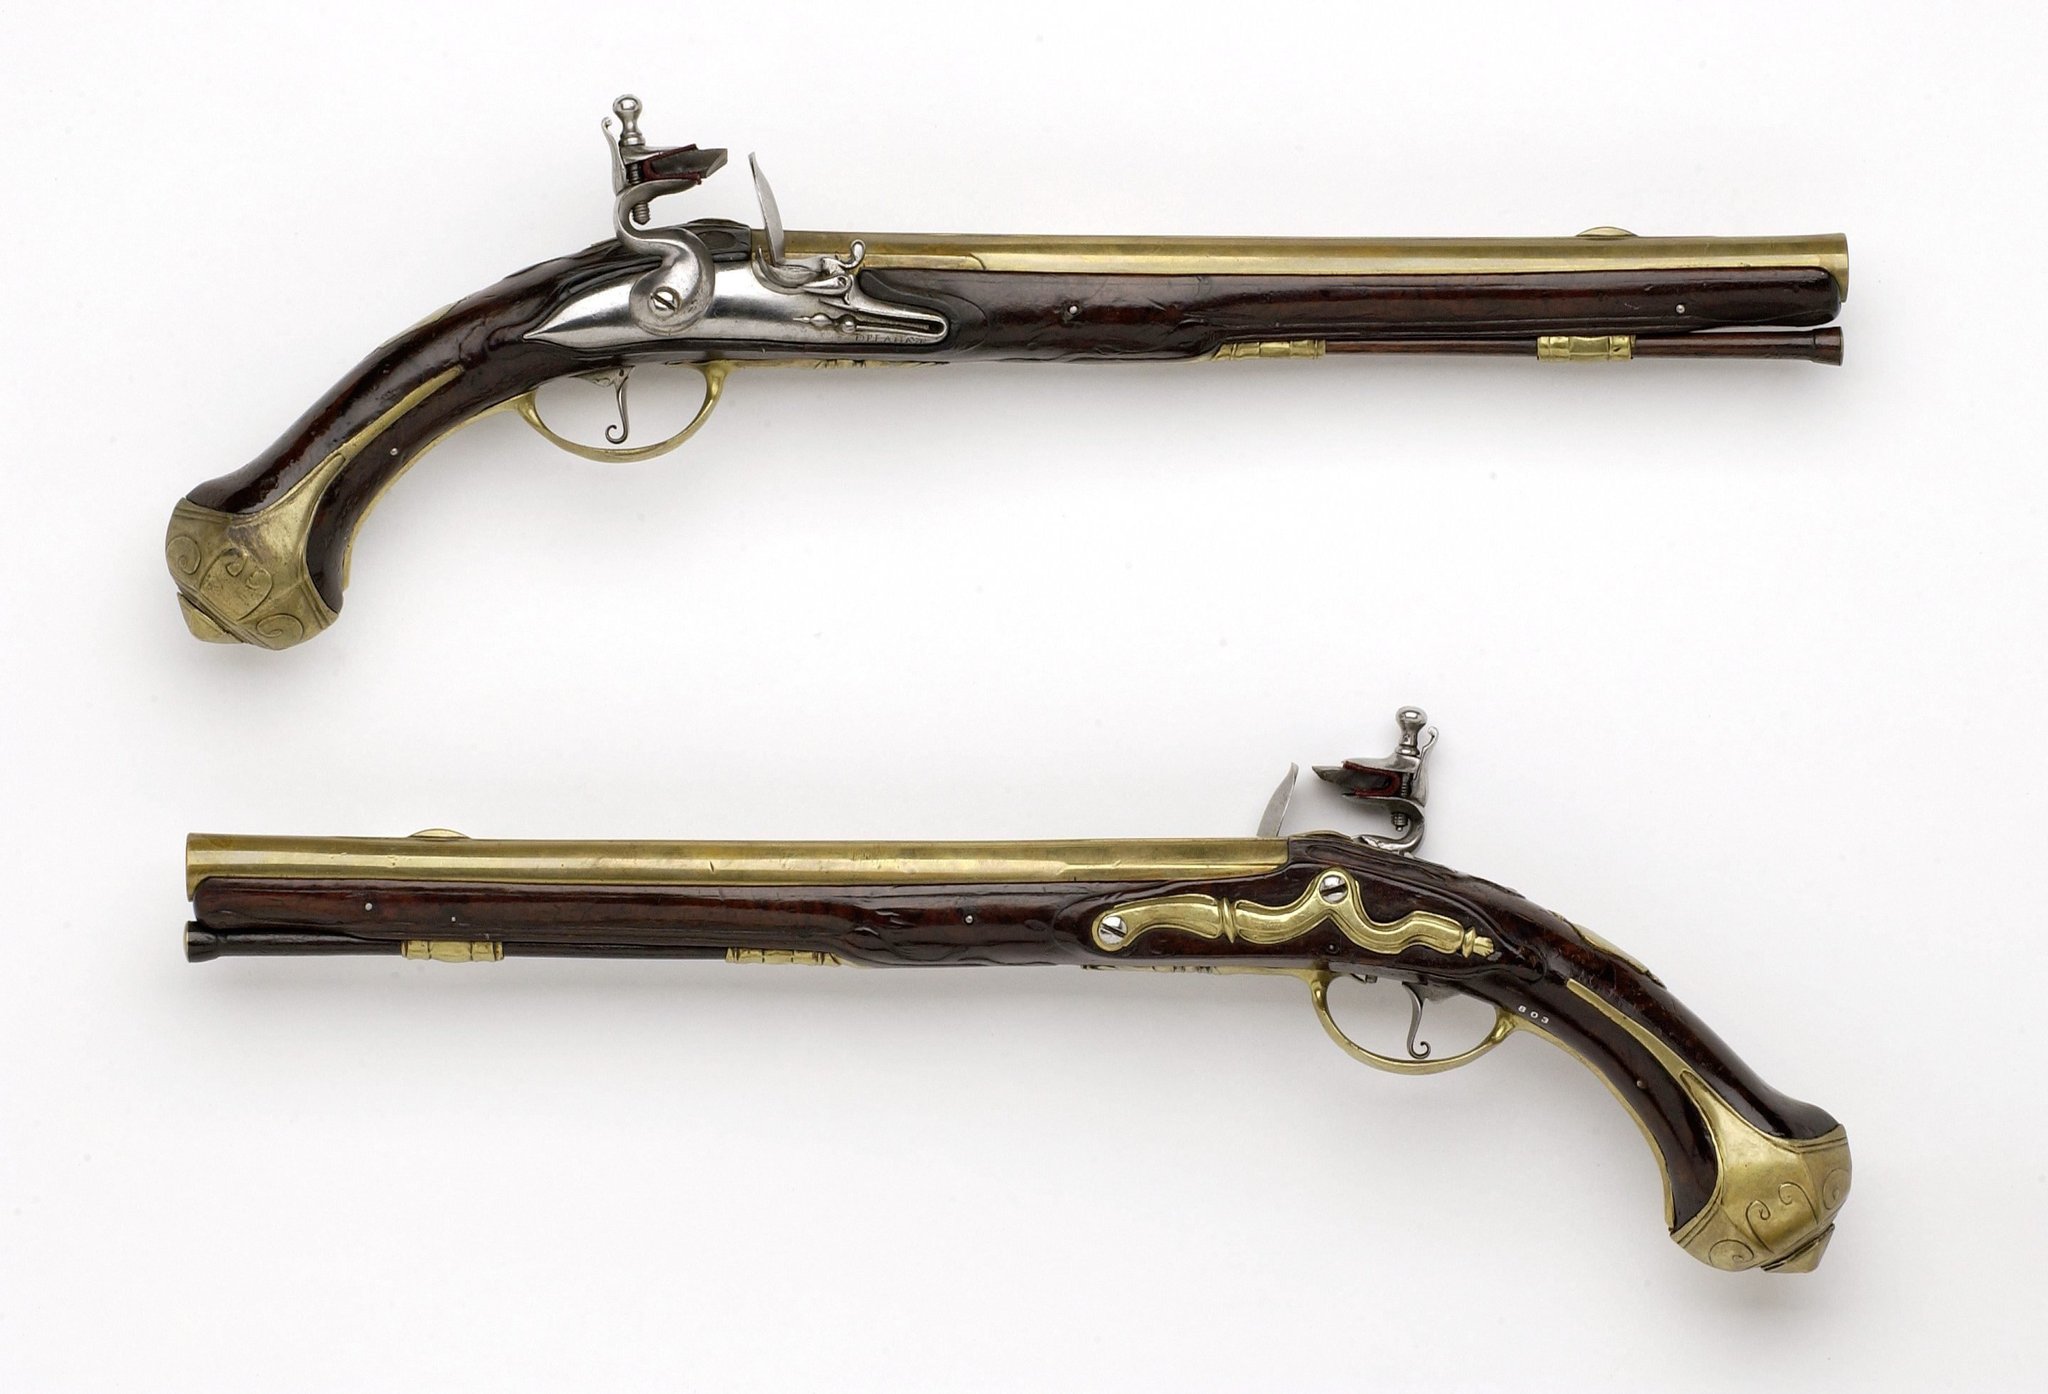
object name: flintlock pistol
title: Militair vuursteenpistool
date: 1705-1710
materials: brass, stone, iron, wood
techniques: printing, cutting, engraving, gilding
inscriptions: : ‘IG’, inscription: ‘DELAHAYE’